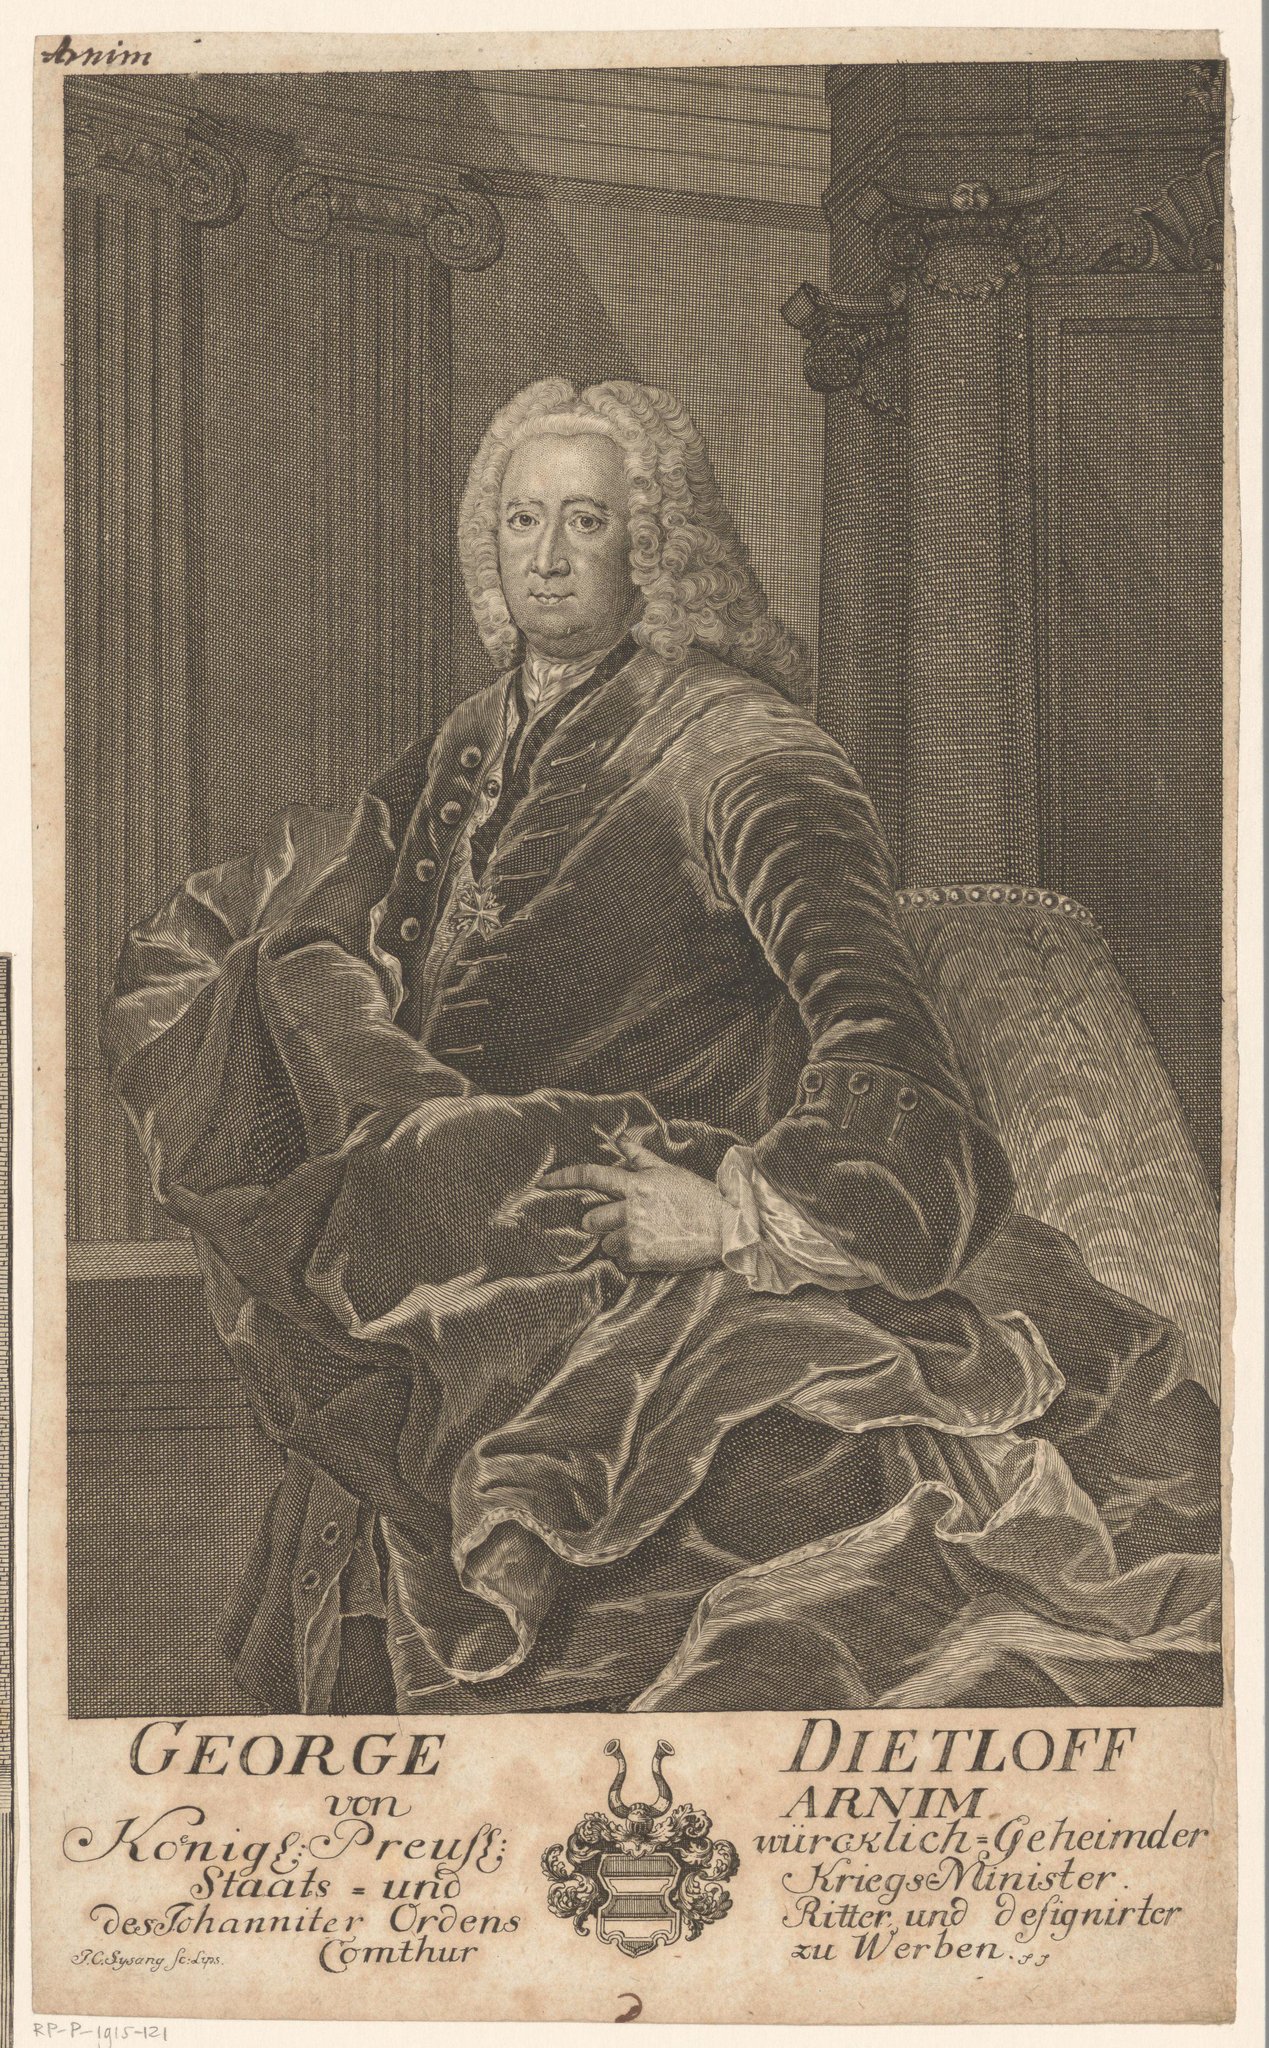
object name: print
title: Portret van Georg Dietloff von Arnim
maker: johann christoph sysang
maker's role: print maker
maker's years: 1703-1757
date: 1749-1757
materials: paper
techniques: engraving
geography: leipzig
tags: berlin, knighthood order (with name) - insignia of a knighthood order, e.g.: badge, chain (with name of order), historical persons, armorial bearing, heraldry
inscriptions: collector's mark: Lugt 2228